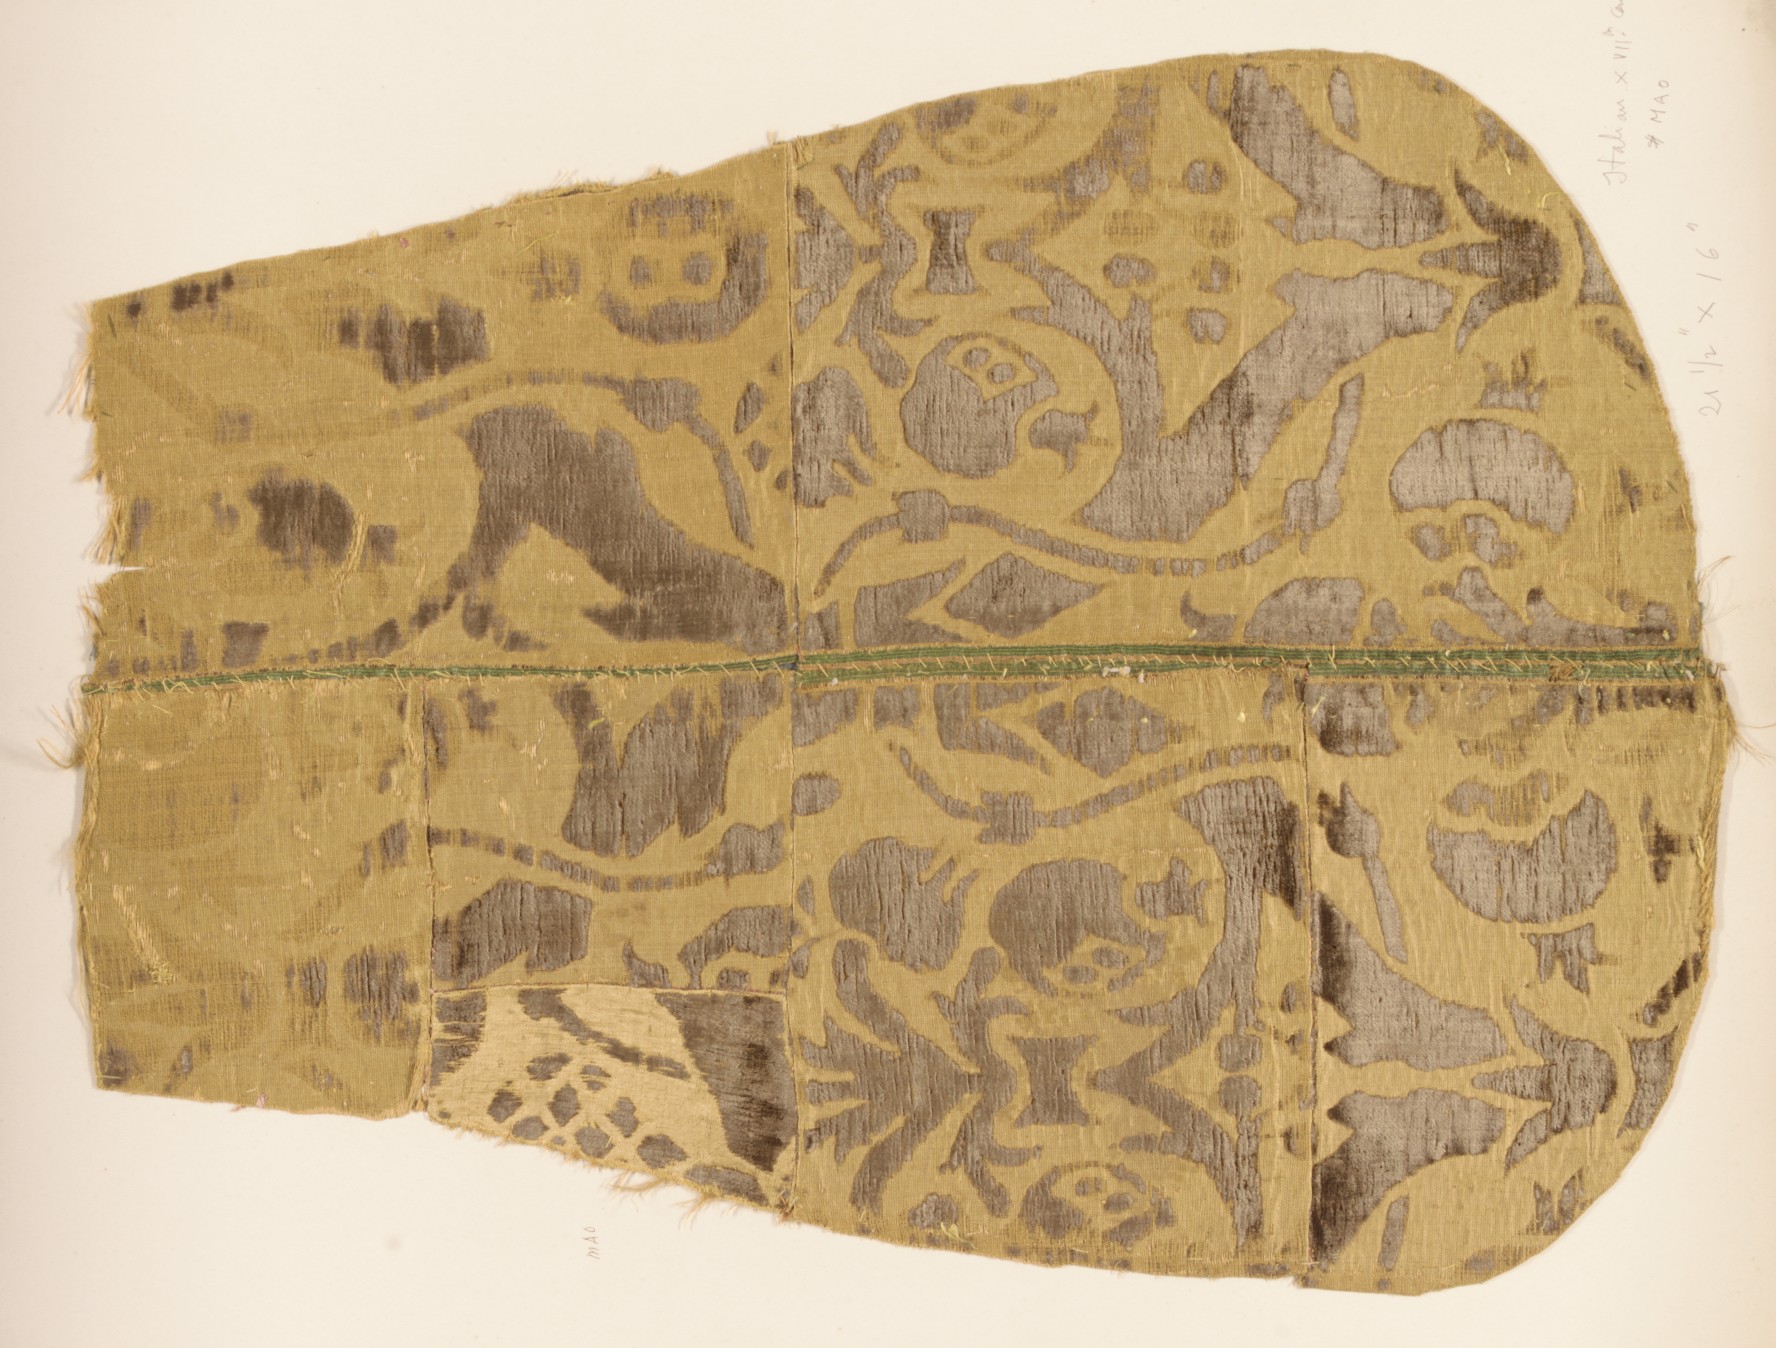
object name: fragment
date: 1601-1700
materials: silk